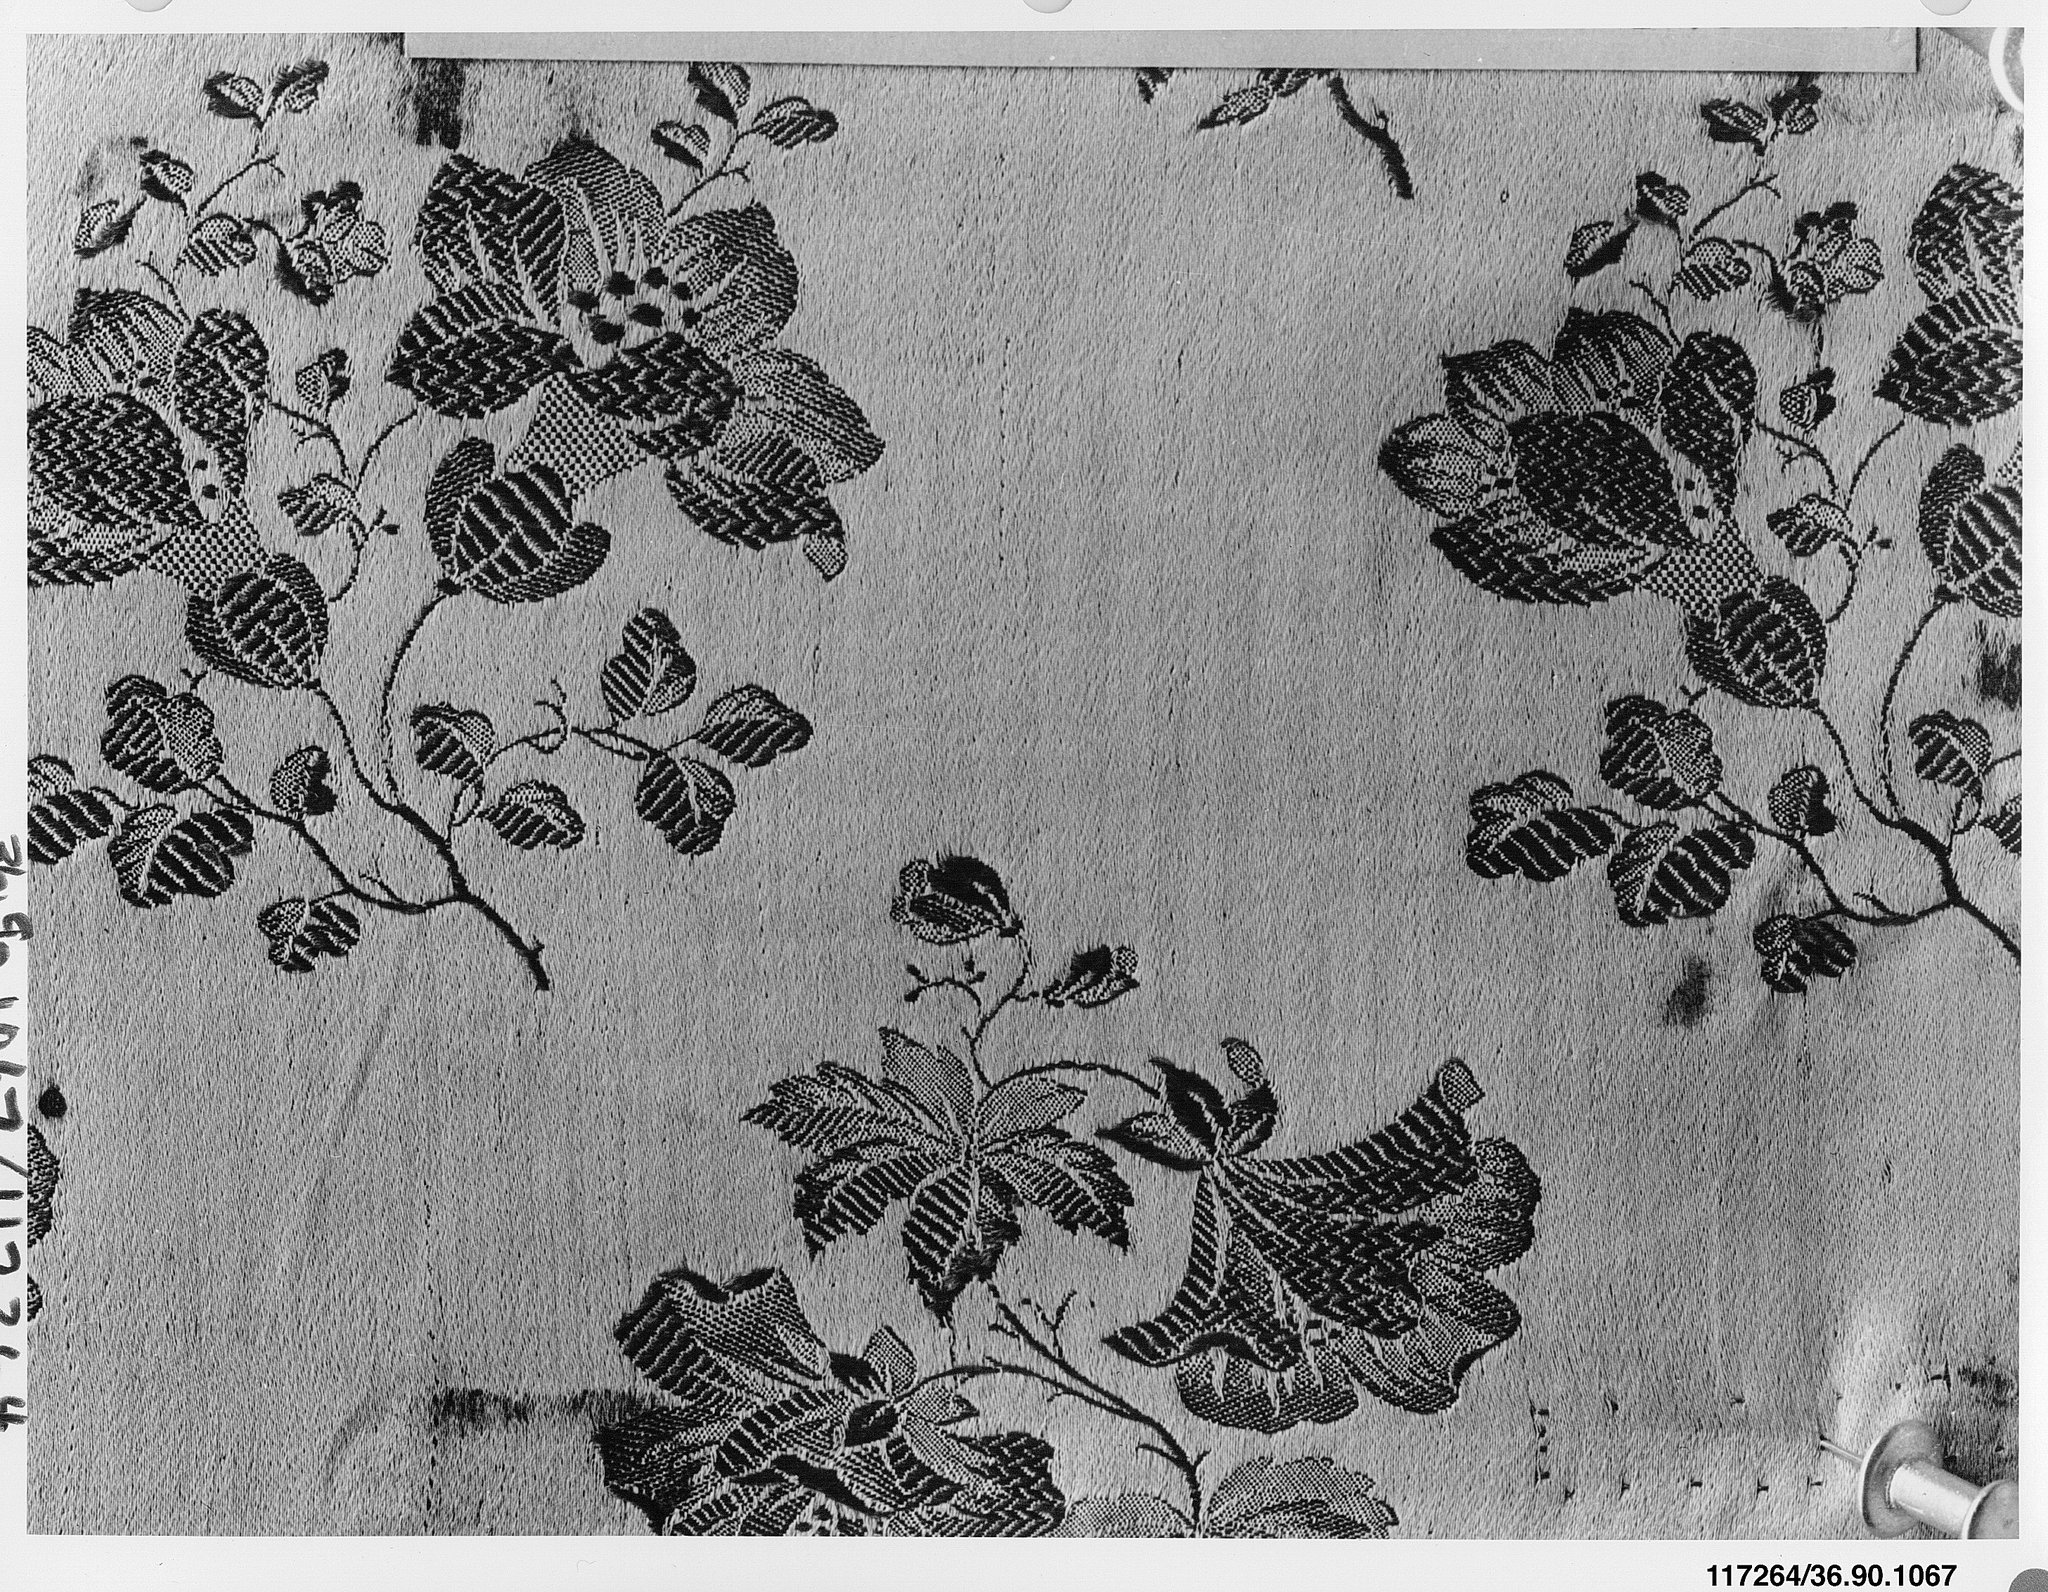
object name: piece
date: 1835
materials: silk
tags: flowers,leaves